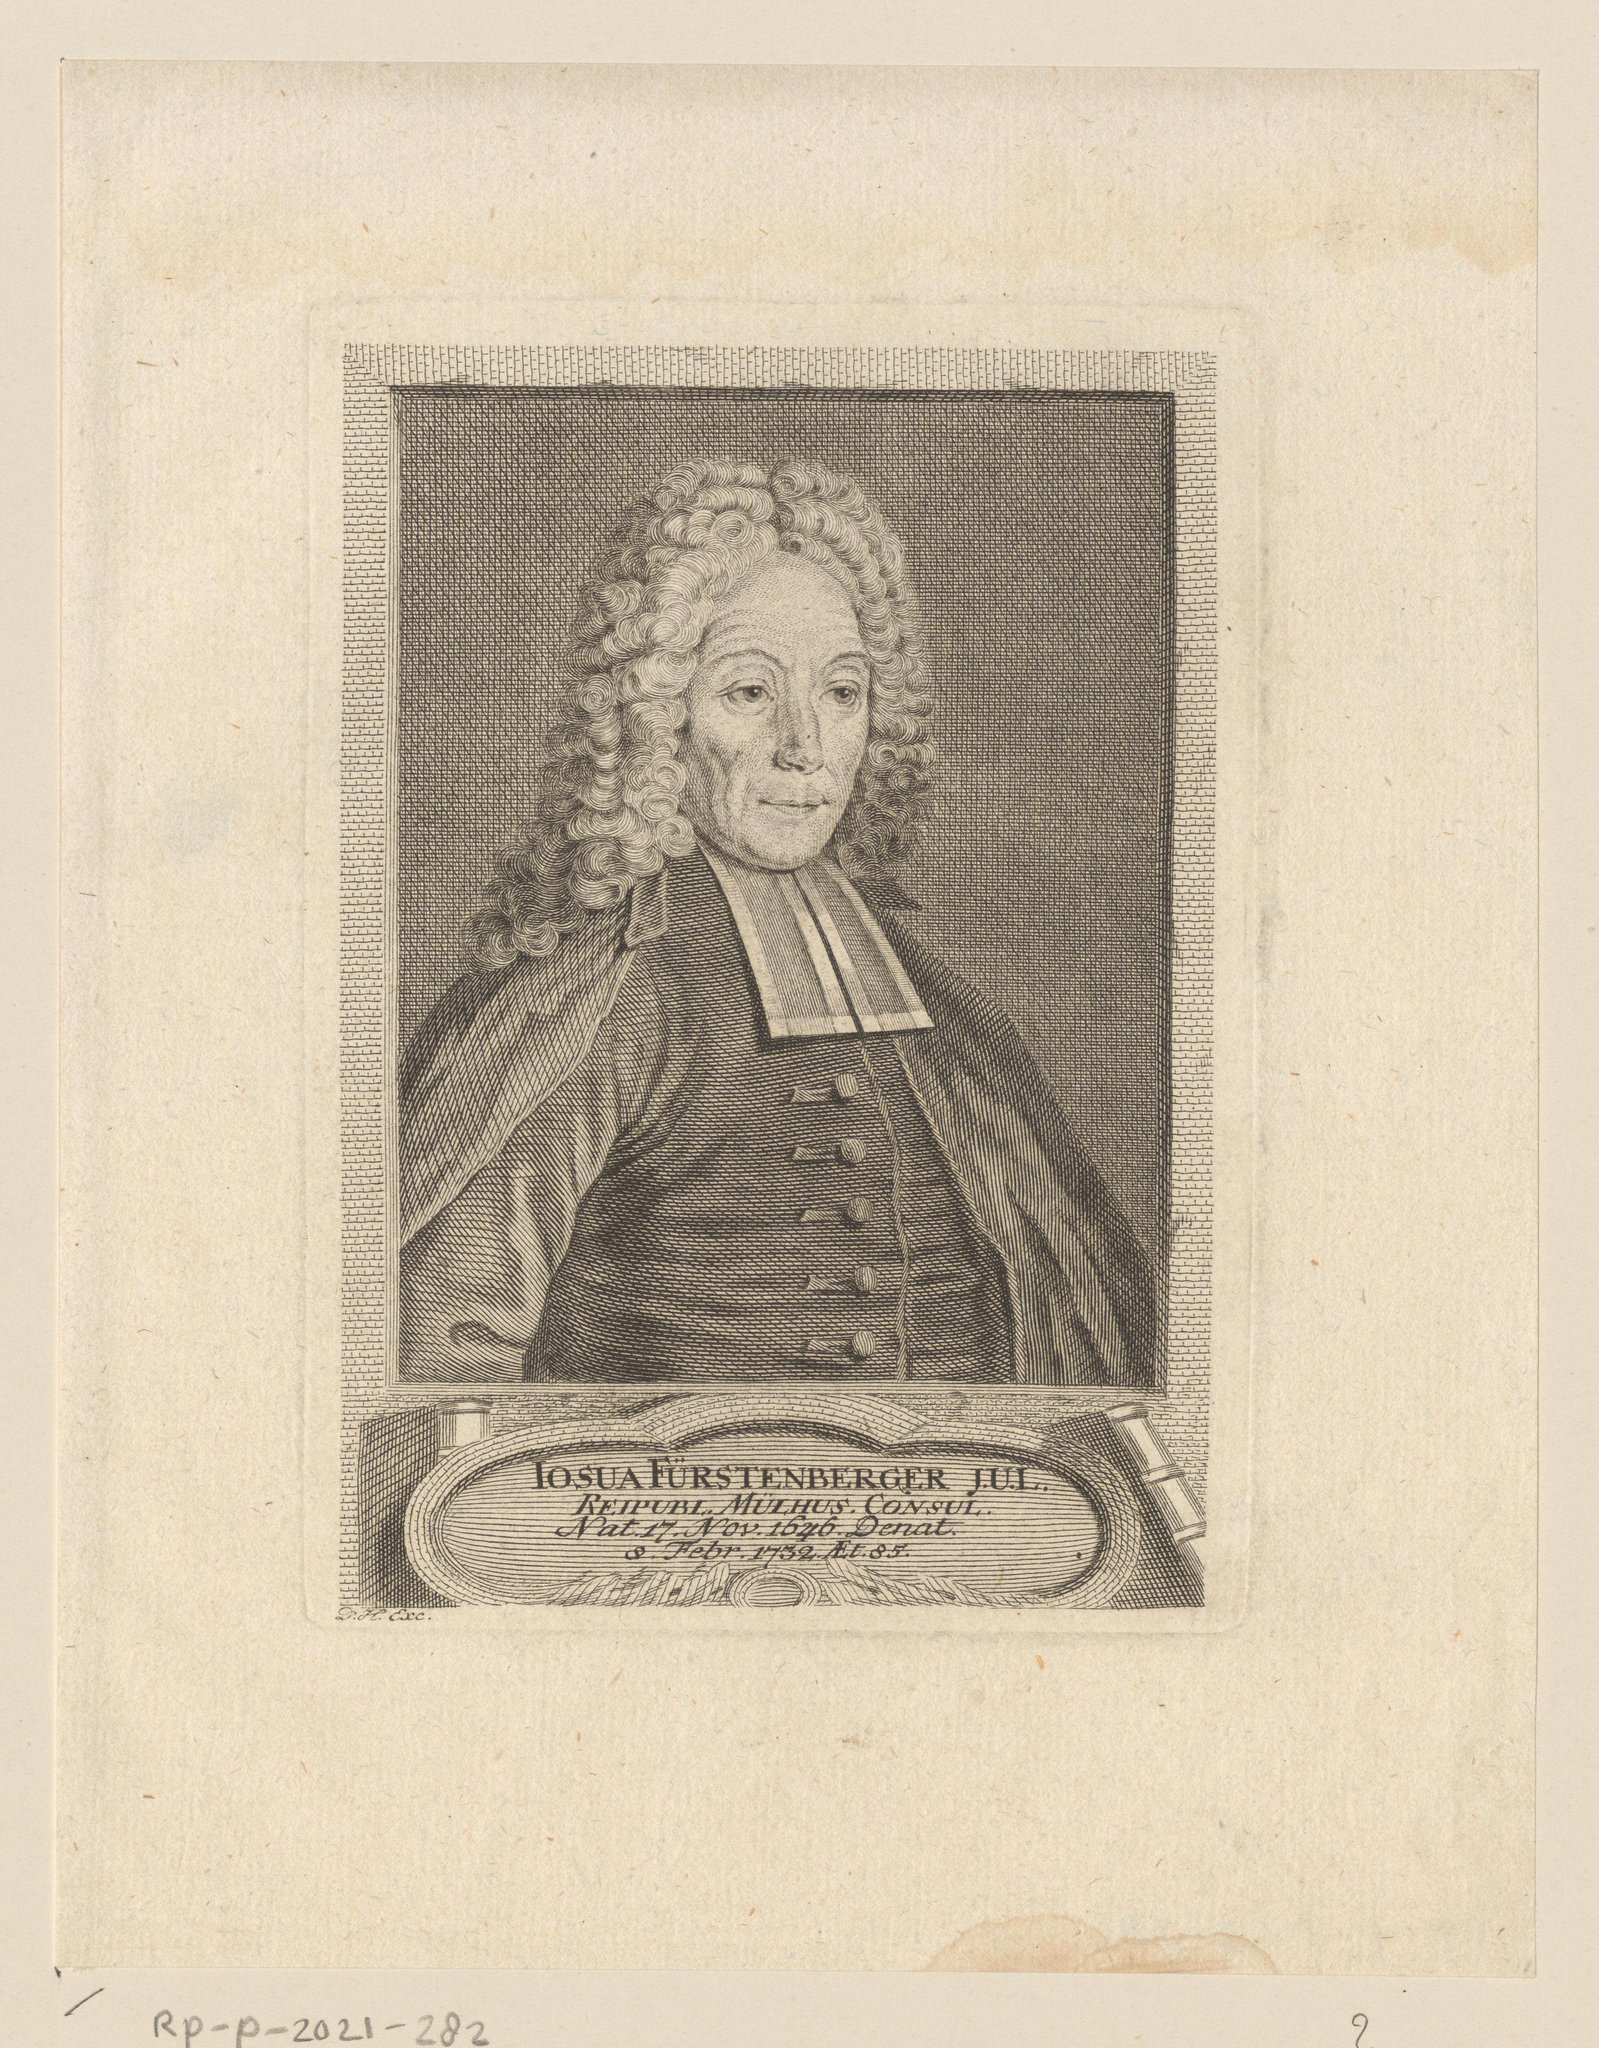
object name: print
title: Portret van Josua Fürstenberger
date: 1732-1799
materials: paper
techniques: engraving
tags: mayor, historical persons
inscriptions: monogram: ‘D.H.’